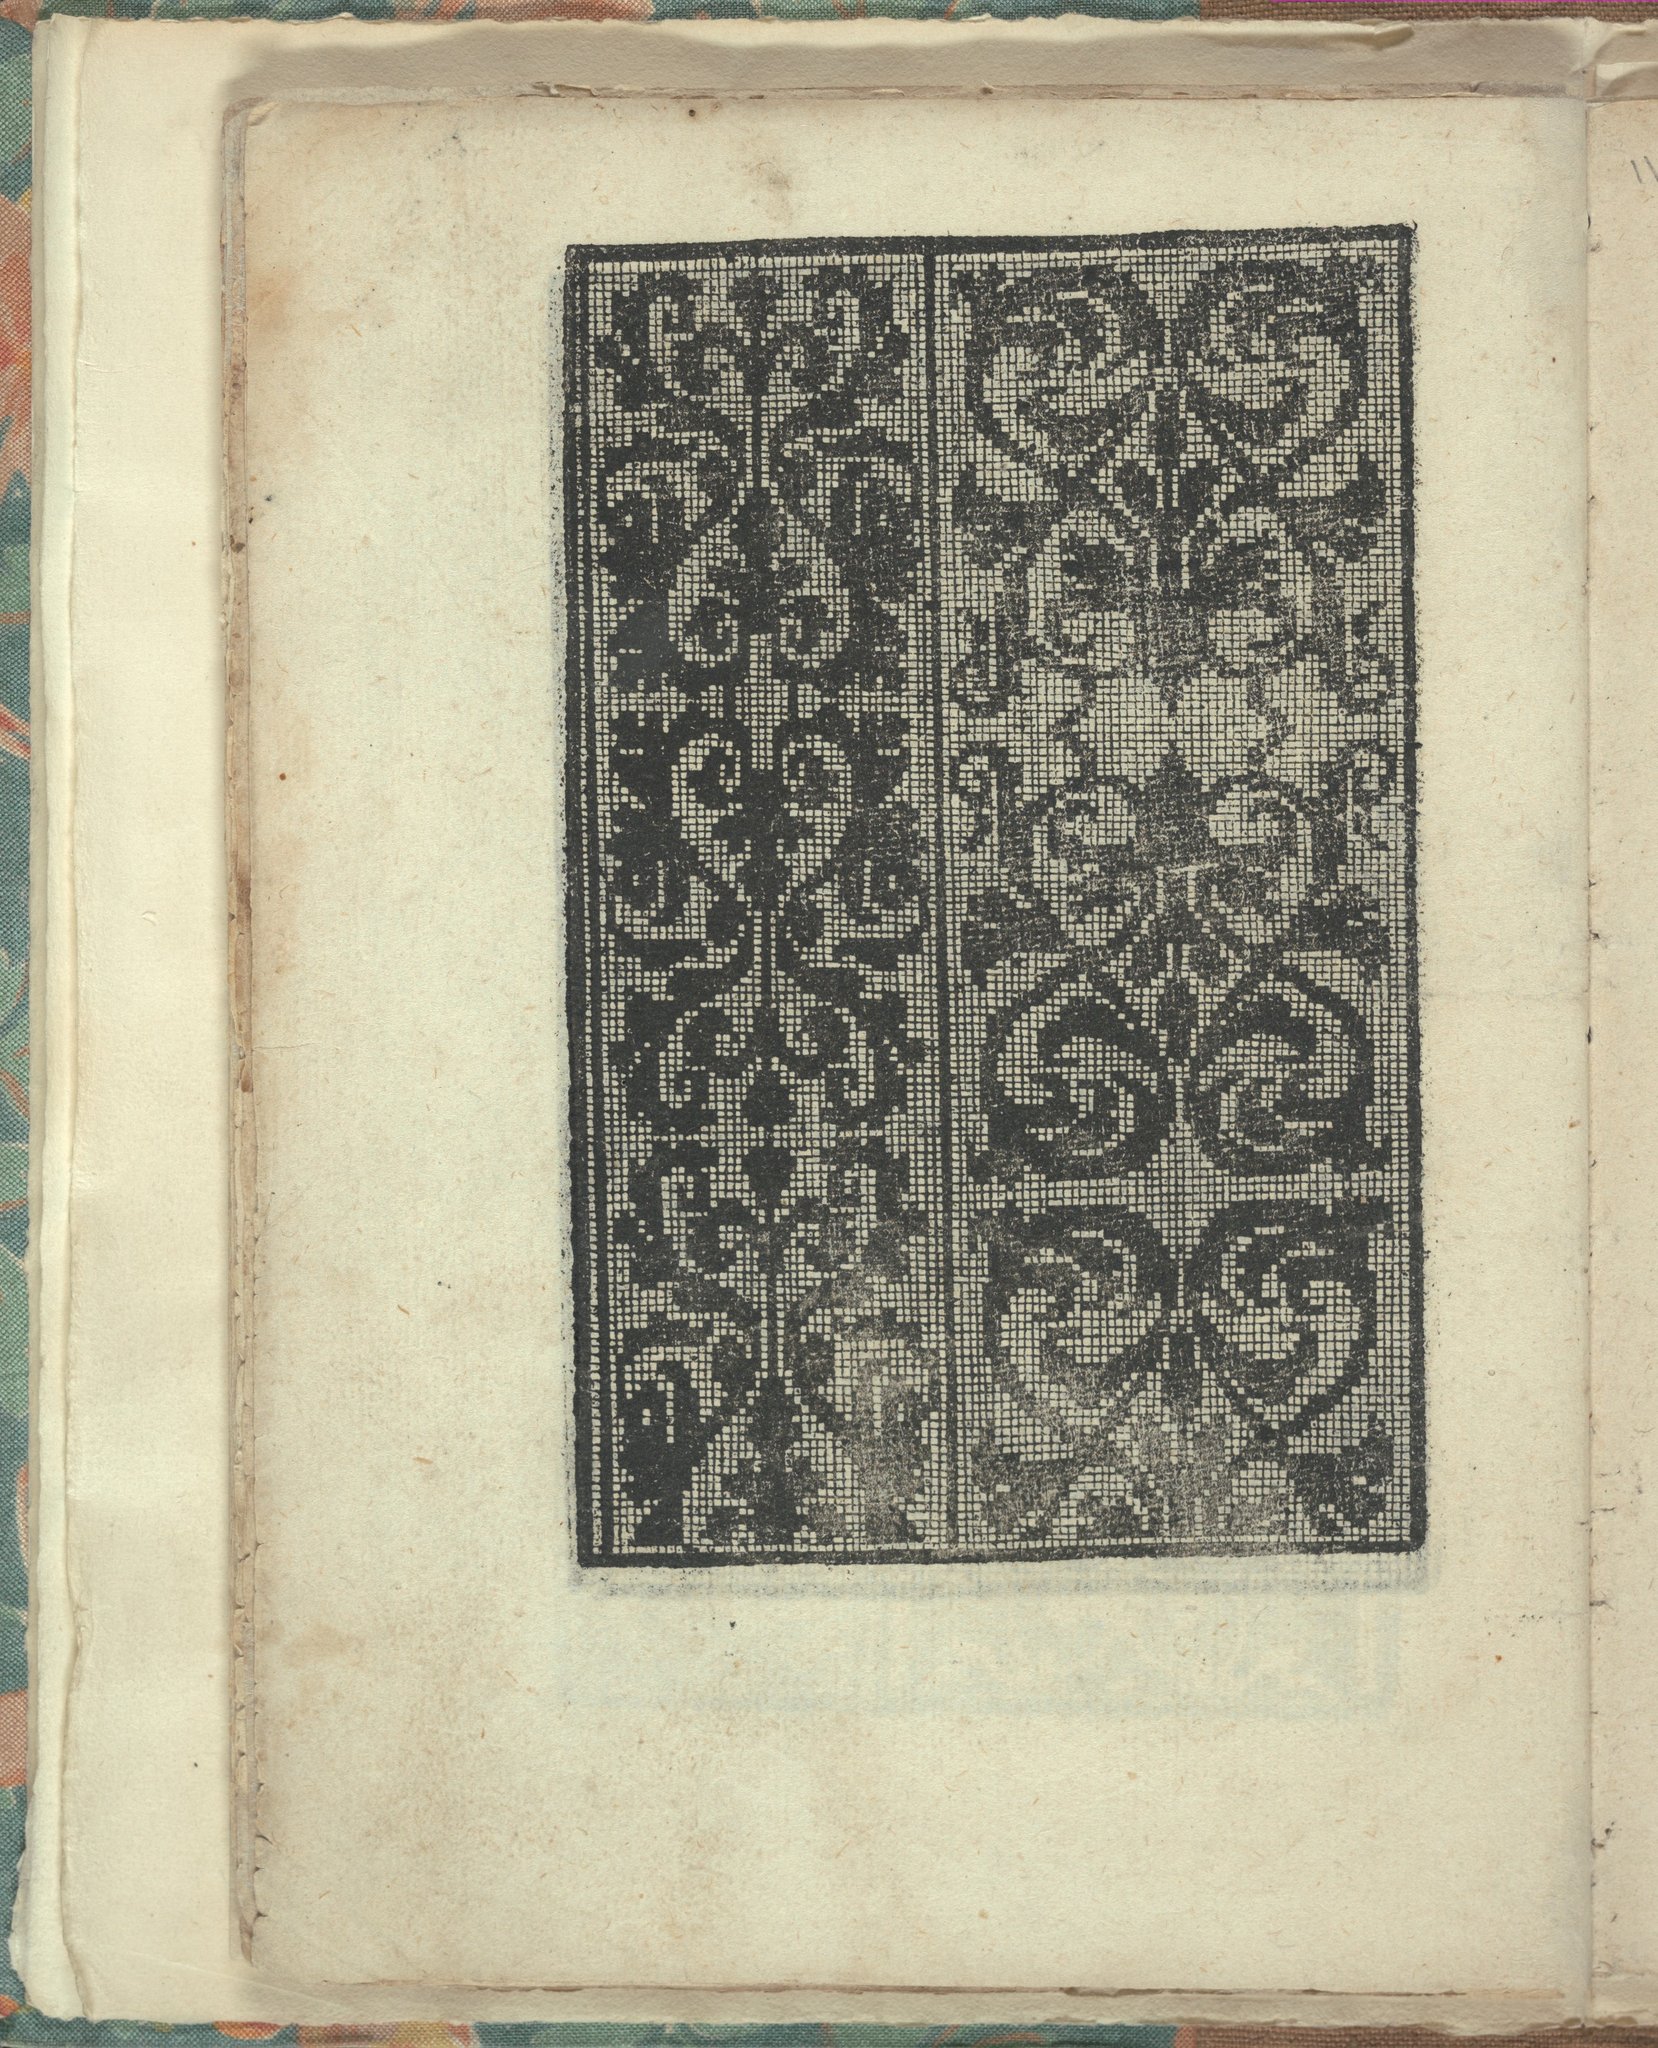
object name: book print ornament architecture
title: Opera Nova Universali intitulata Corona di racammi, page 29 (verso)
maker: giovanni andrea vavassore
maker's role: publisher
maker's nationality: italian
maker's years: 1530-1573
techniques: woodcut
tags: ornament